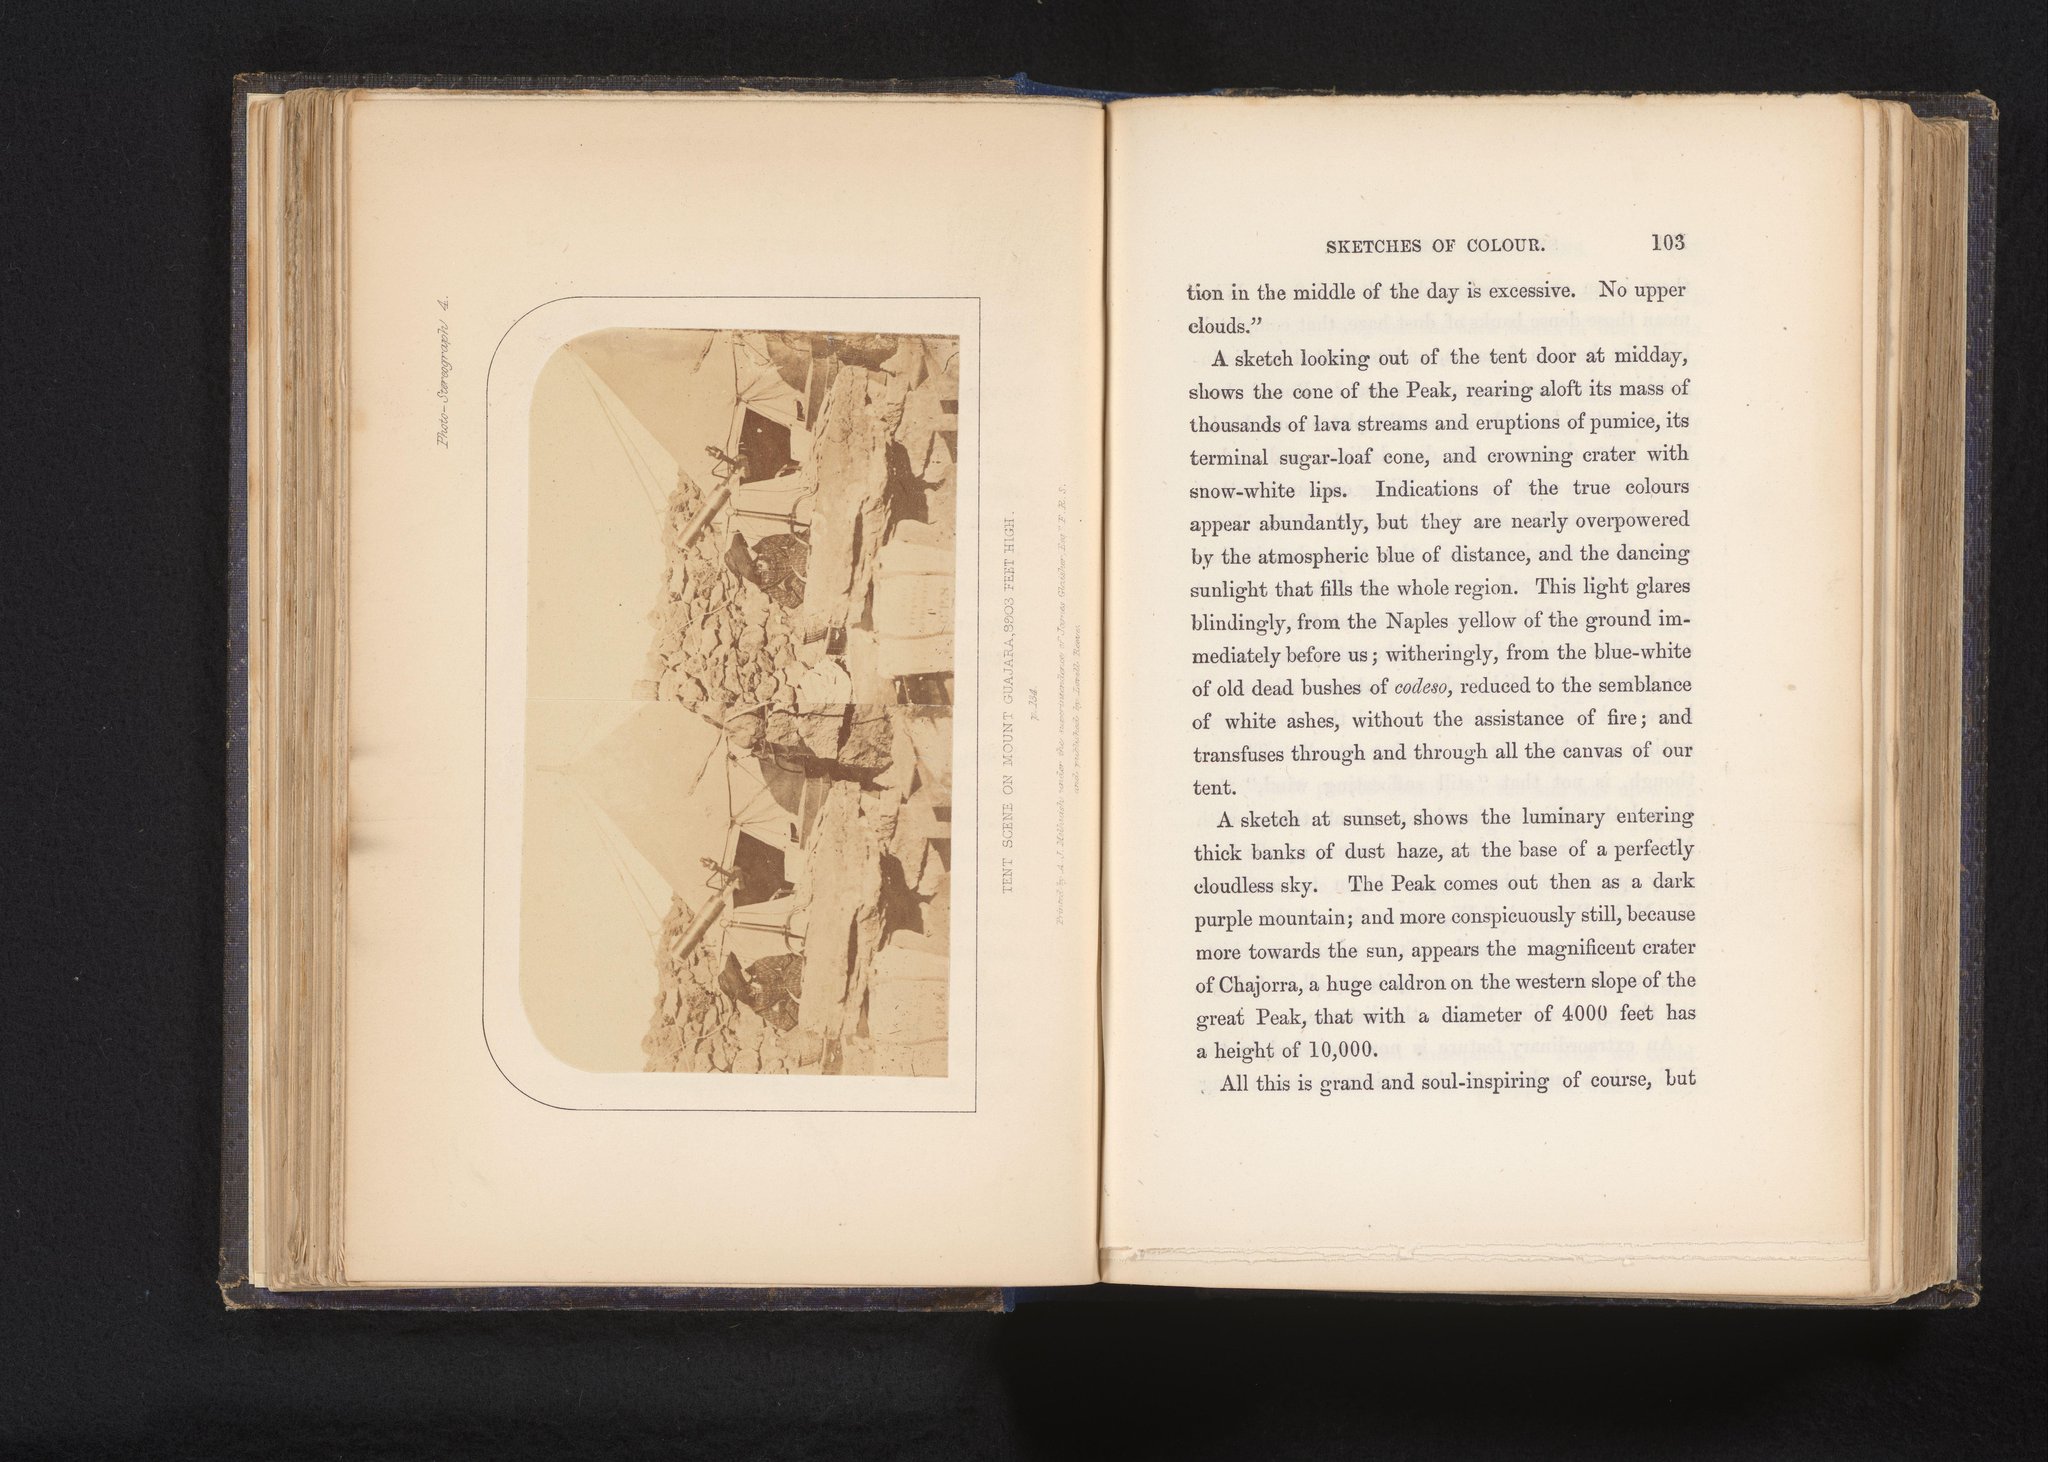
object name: stereograph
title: Tent scene of Mount Guajara, 8903 feet high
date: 1856-1858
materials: paper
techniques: albumen print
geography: london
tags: tent-camp, telescope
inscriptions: inscription: ‘Photo-Stereograph 4.’